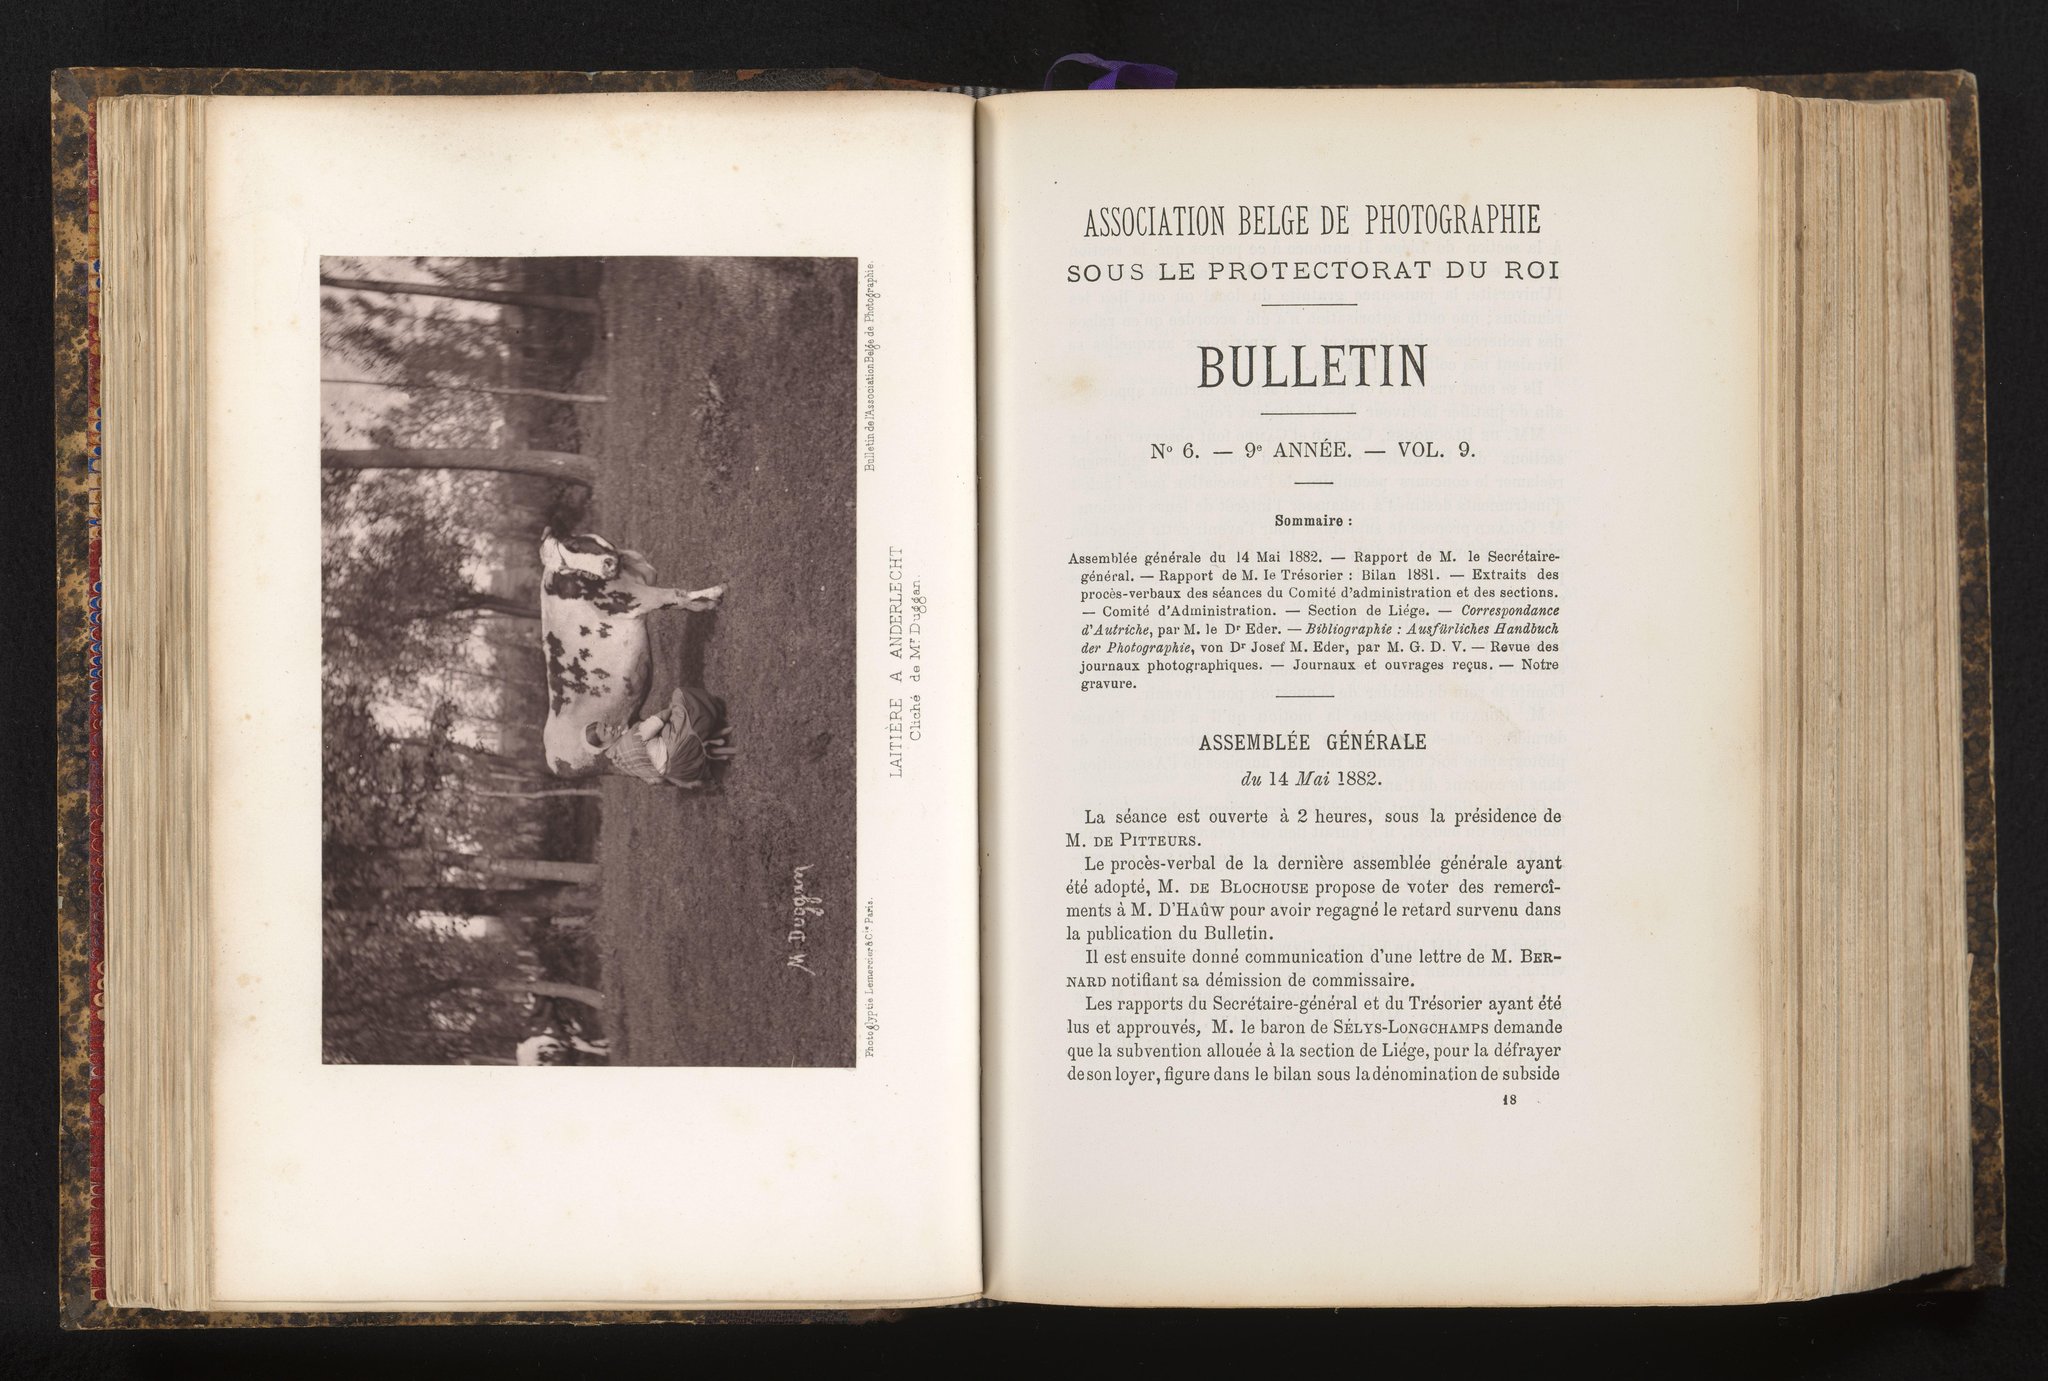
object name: page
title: Laitière a Anderlecht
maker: m. duggan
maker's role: engineer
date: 1878-1883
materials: paper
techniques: woodburytype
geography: anderlecht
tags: cow, adult woman, milking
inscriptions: inscription: ‘Bulletin de l'Association belge de Photographie’